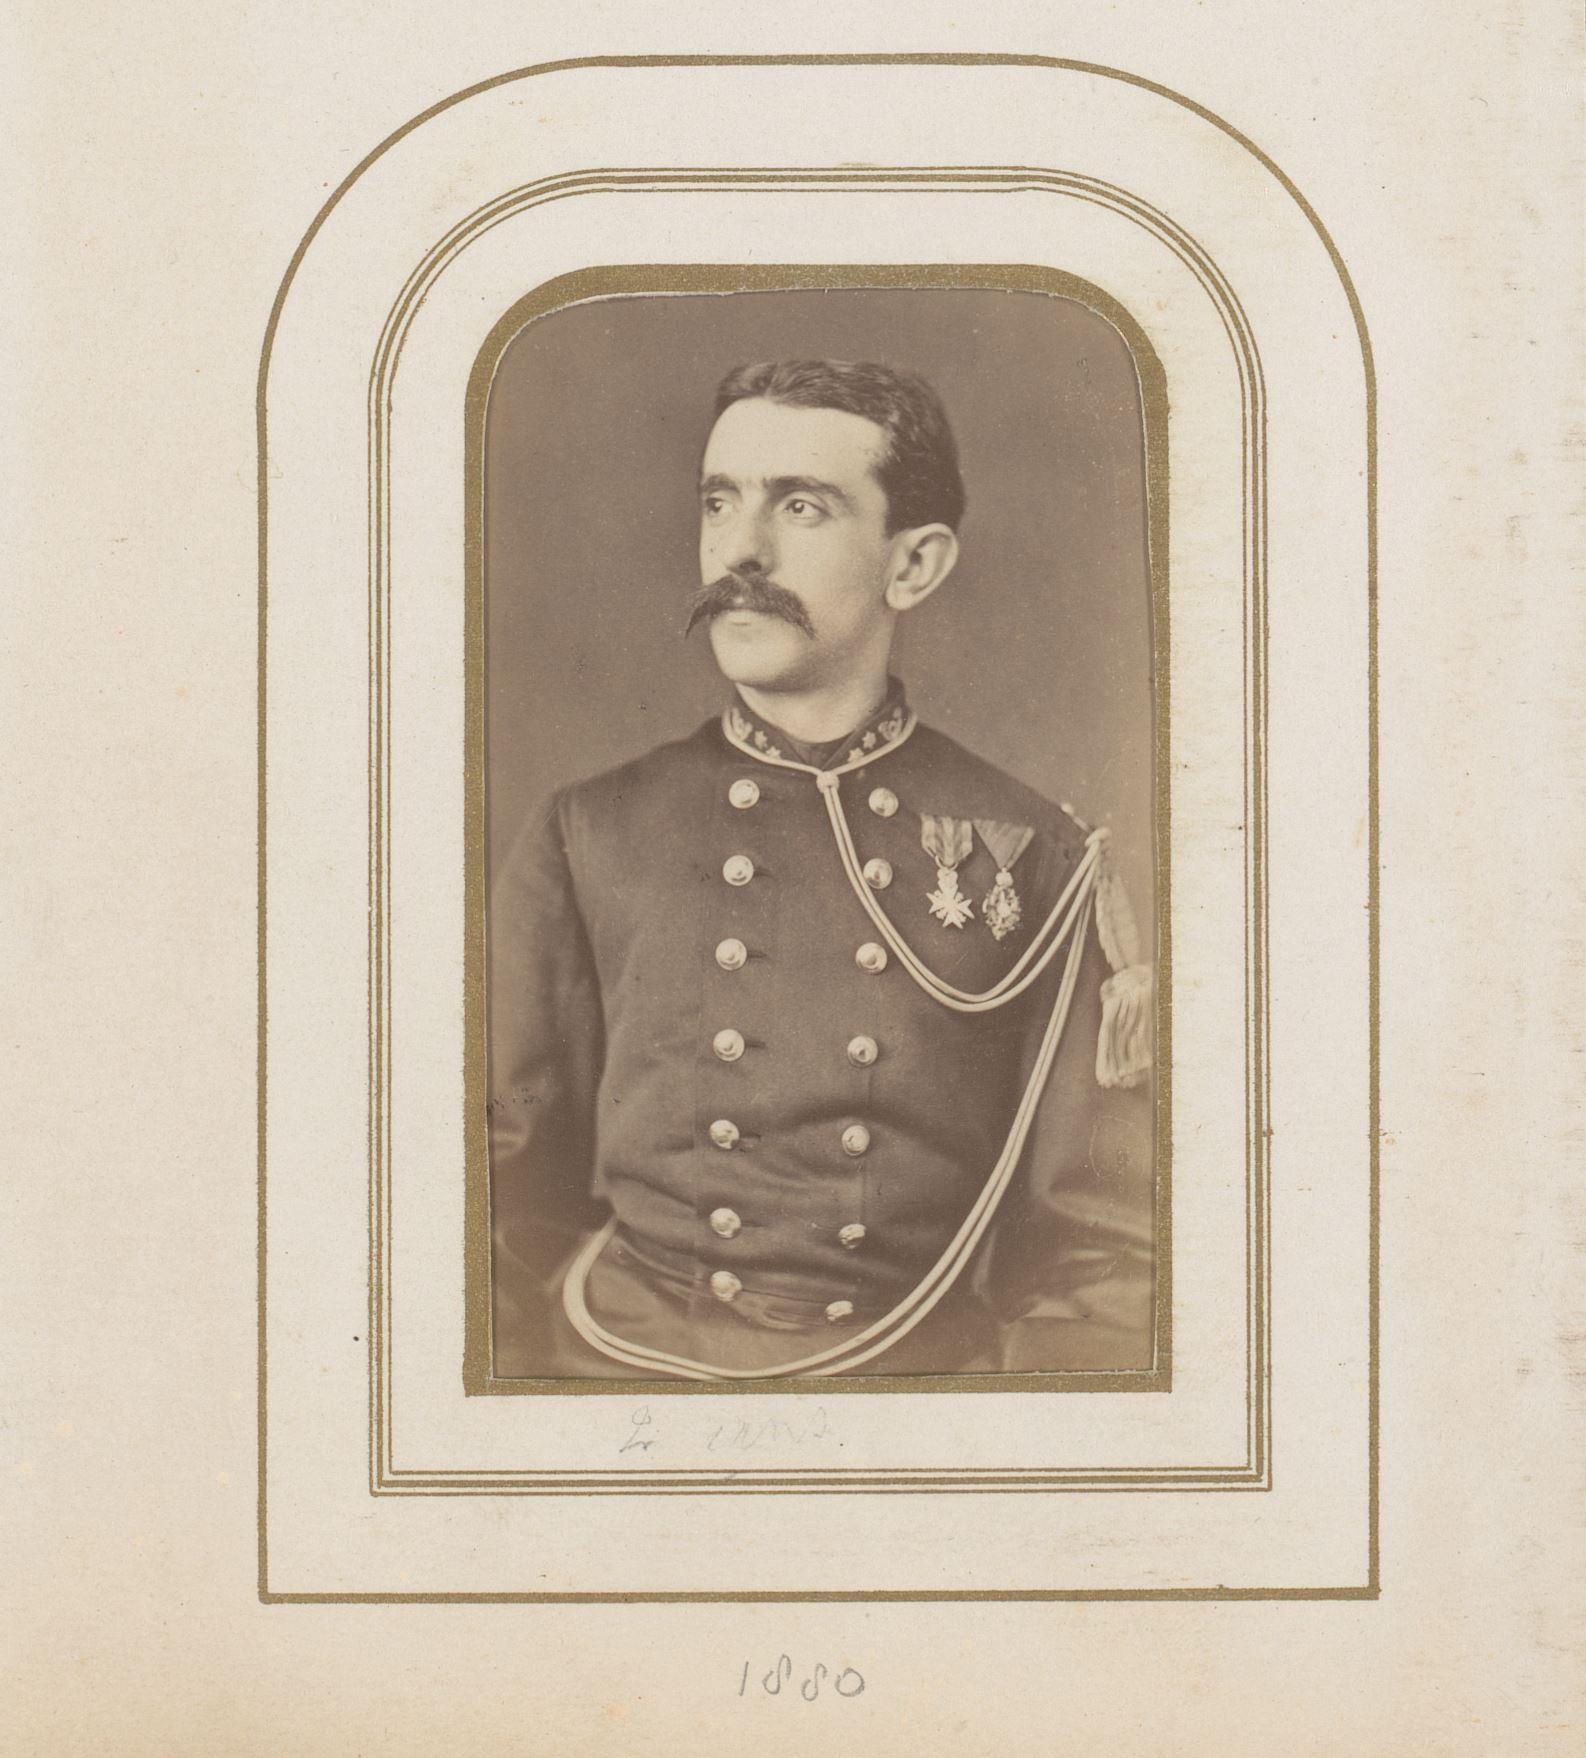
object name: carte de visite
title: Portret van een man met snor in uniform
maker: j. rothermel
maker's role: fotograaf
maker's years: 1836-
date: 1880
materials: cardboard, photographic support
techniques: albumen print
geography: brussels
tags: moustache, historical persons, (military) uniforms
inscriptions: inscription: ‘Photographe à Primes/ J. Rothermel Place ste Gudule 3 Bruxelles (...)’, annotation: ‘Hommage respectieux/ à mon chef de corps monsieur/ le colonel Lemoine commt/ le regiment des carabiniers [...] 29 octobre 1880’